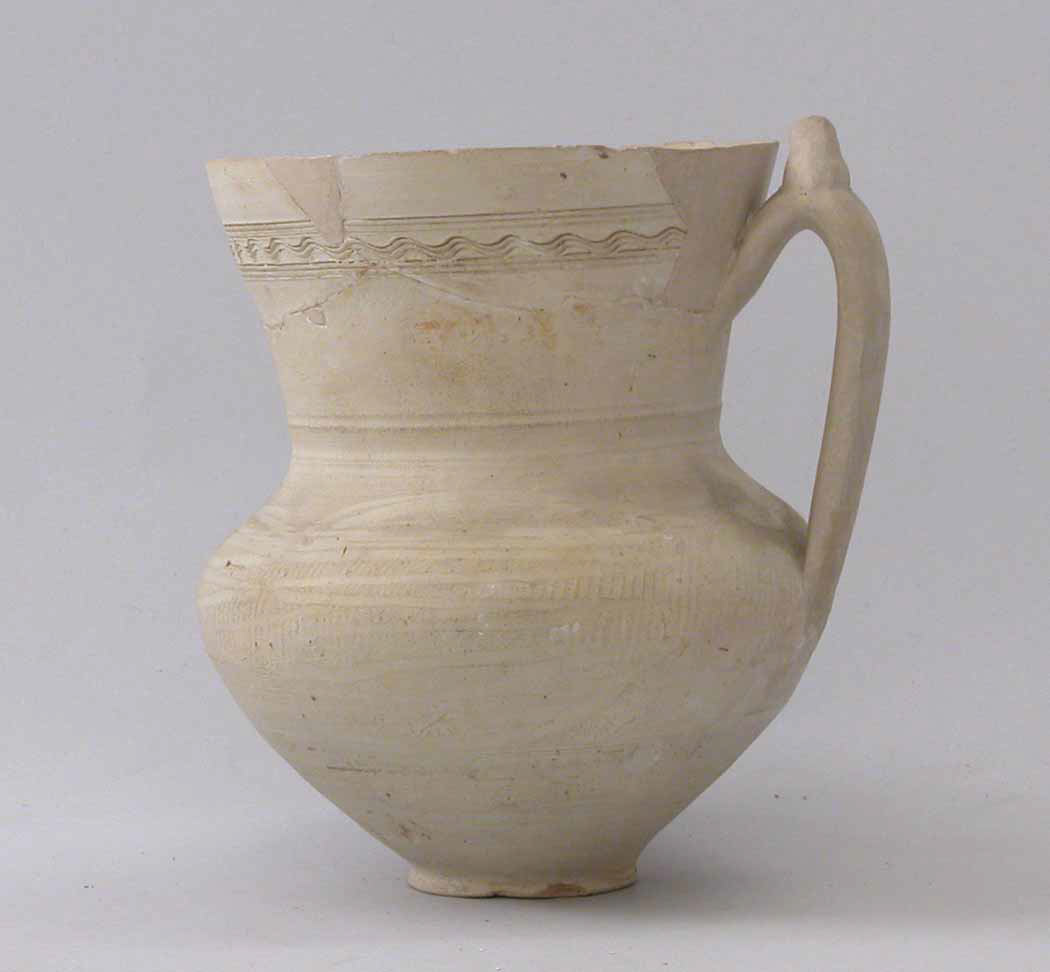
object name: jar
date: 867-1000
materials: earthenware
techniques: incising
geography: iran